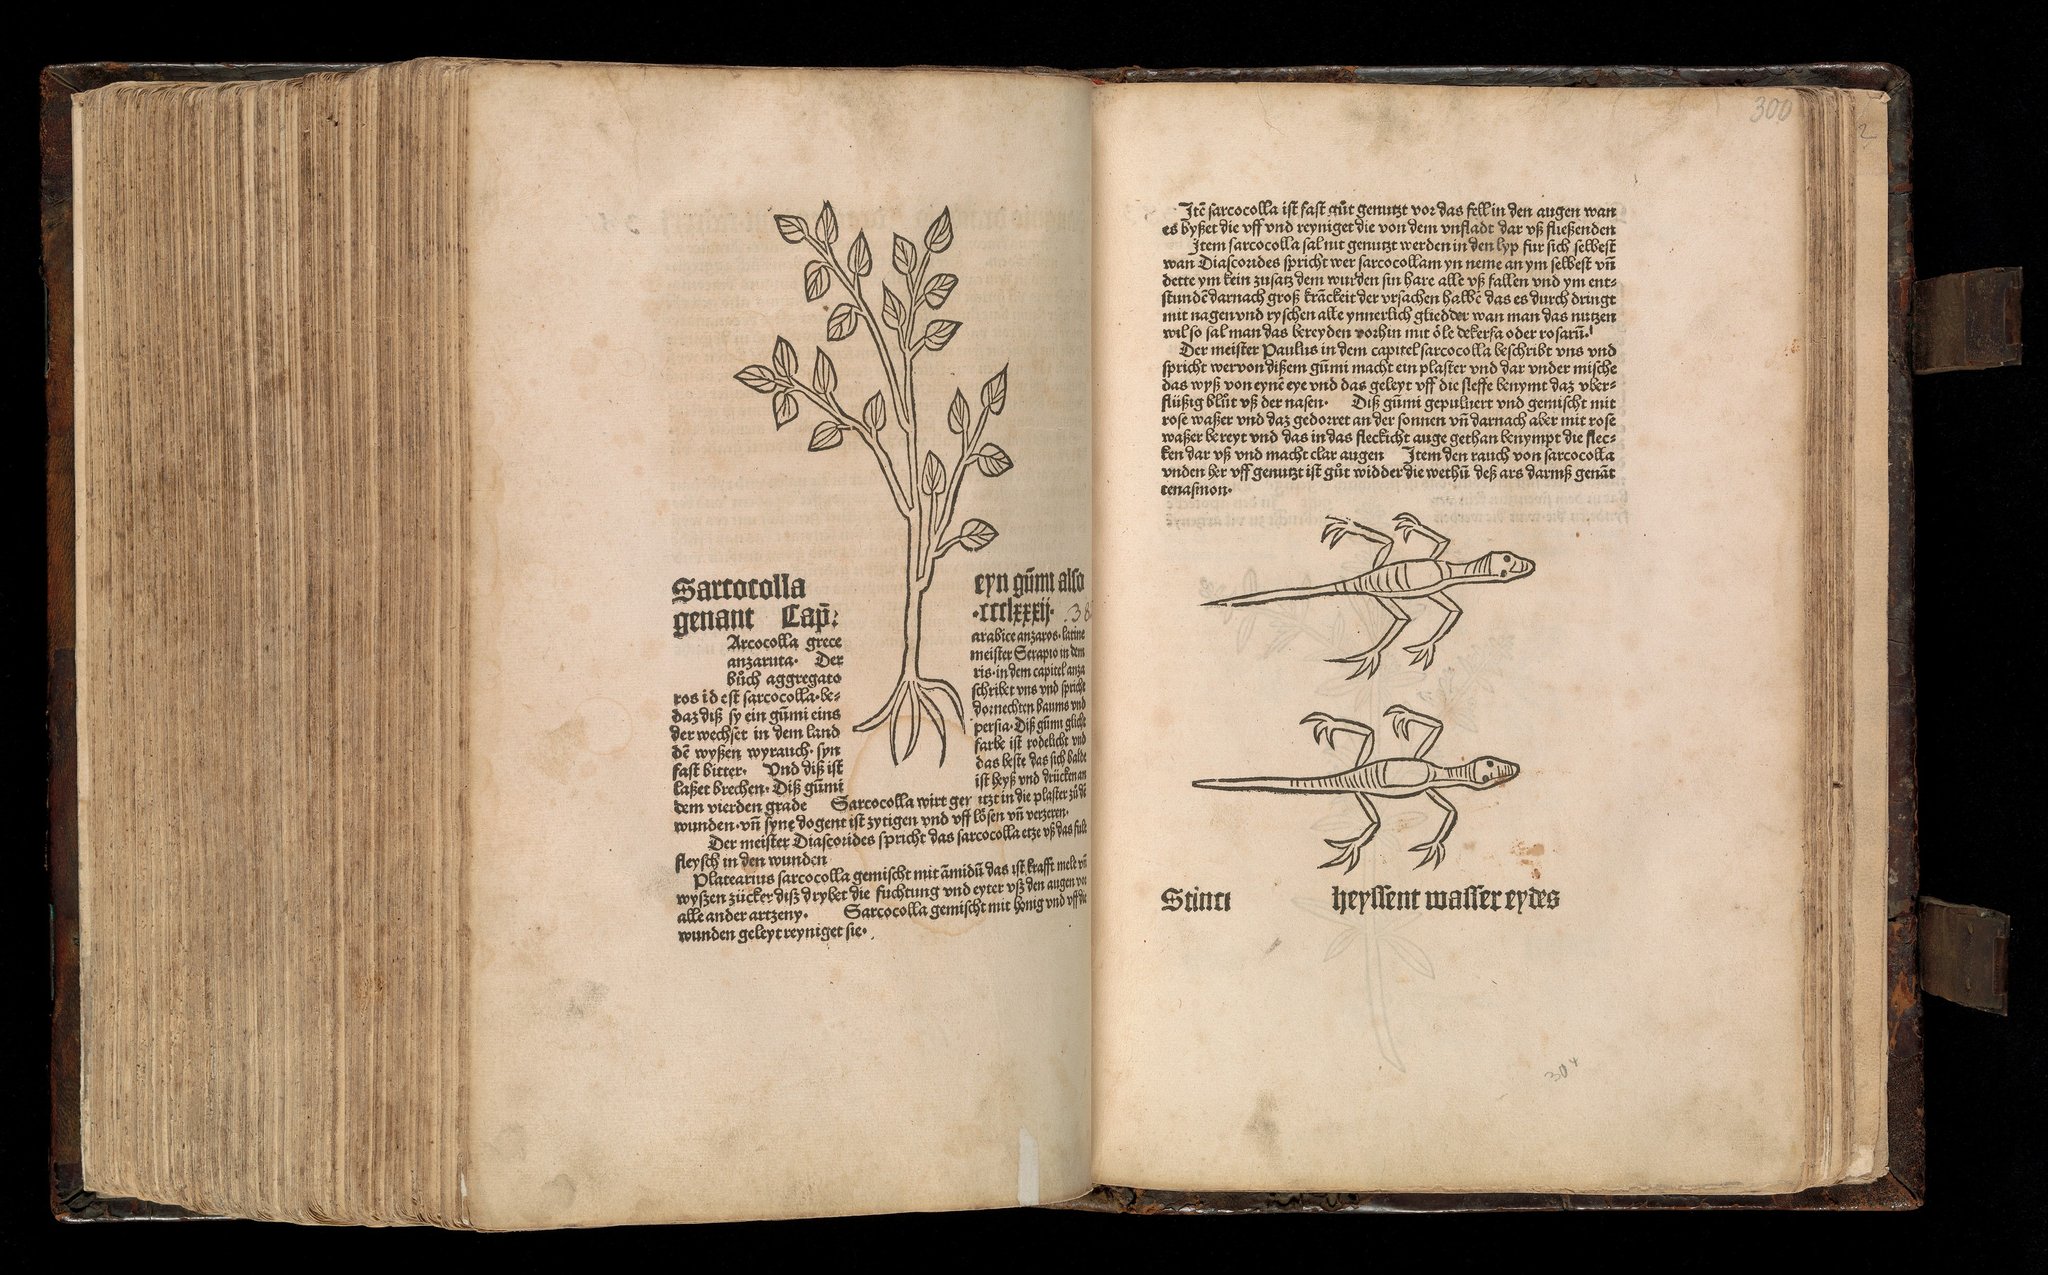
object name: book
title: Gart der gesuntheit - Ortus sanitatis (Herbarius)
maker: peter schöffer the elder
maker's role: publisher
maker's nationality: german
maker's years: 1425-1503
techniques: hand coloring, woodcut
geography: germany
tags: men,female nudes,lizards